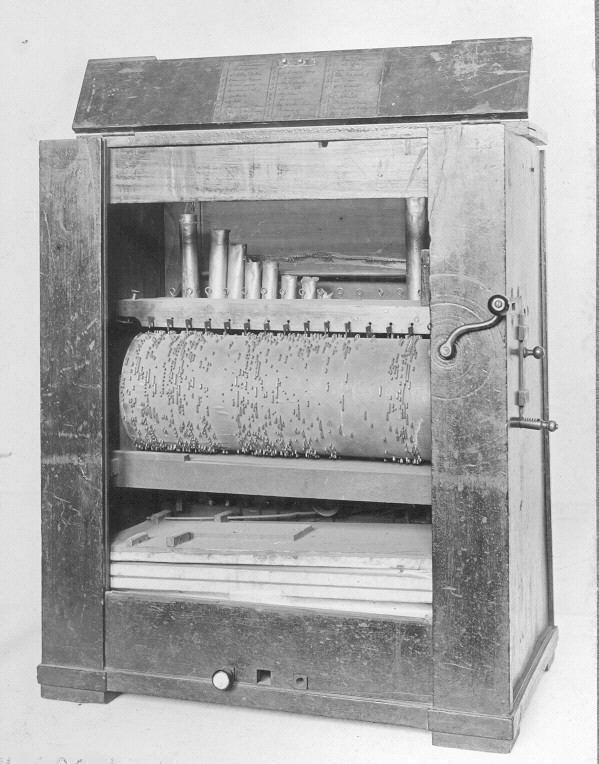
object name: barrel organ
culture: british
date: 1830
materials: wood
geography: united kingdom